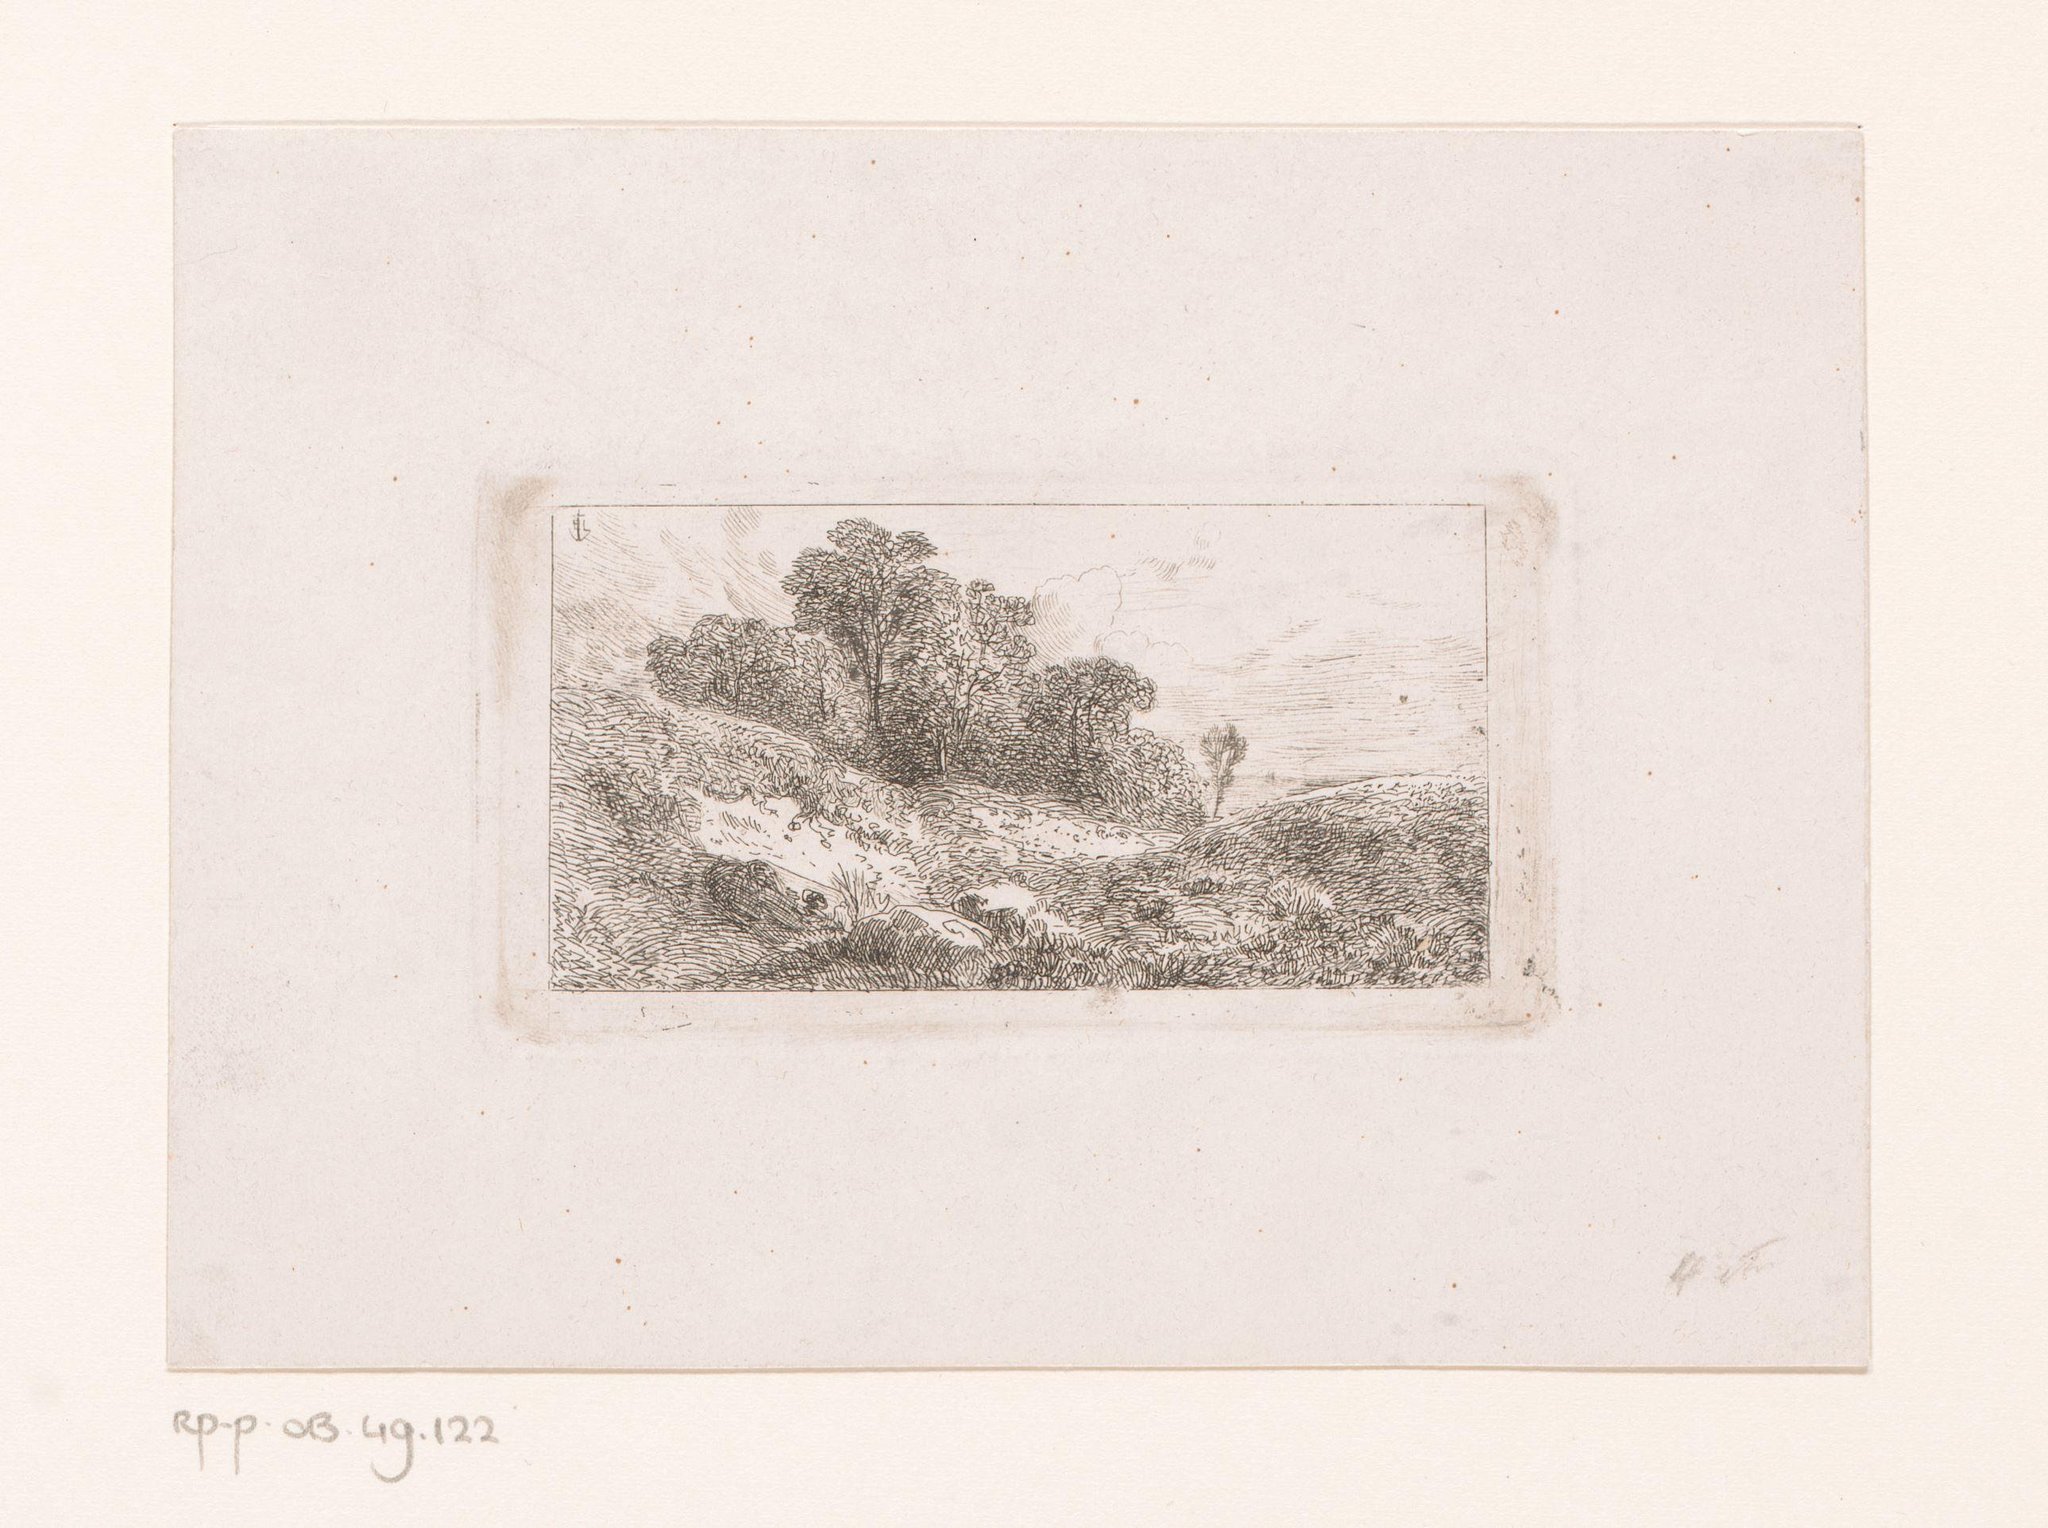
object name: print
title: Duinlandschap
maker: paulus lauters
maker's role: print maker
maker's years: 1806-1875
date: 1816-1875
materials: paper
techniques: etching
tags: dune coast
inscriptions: collector's mark: Lugt 2228